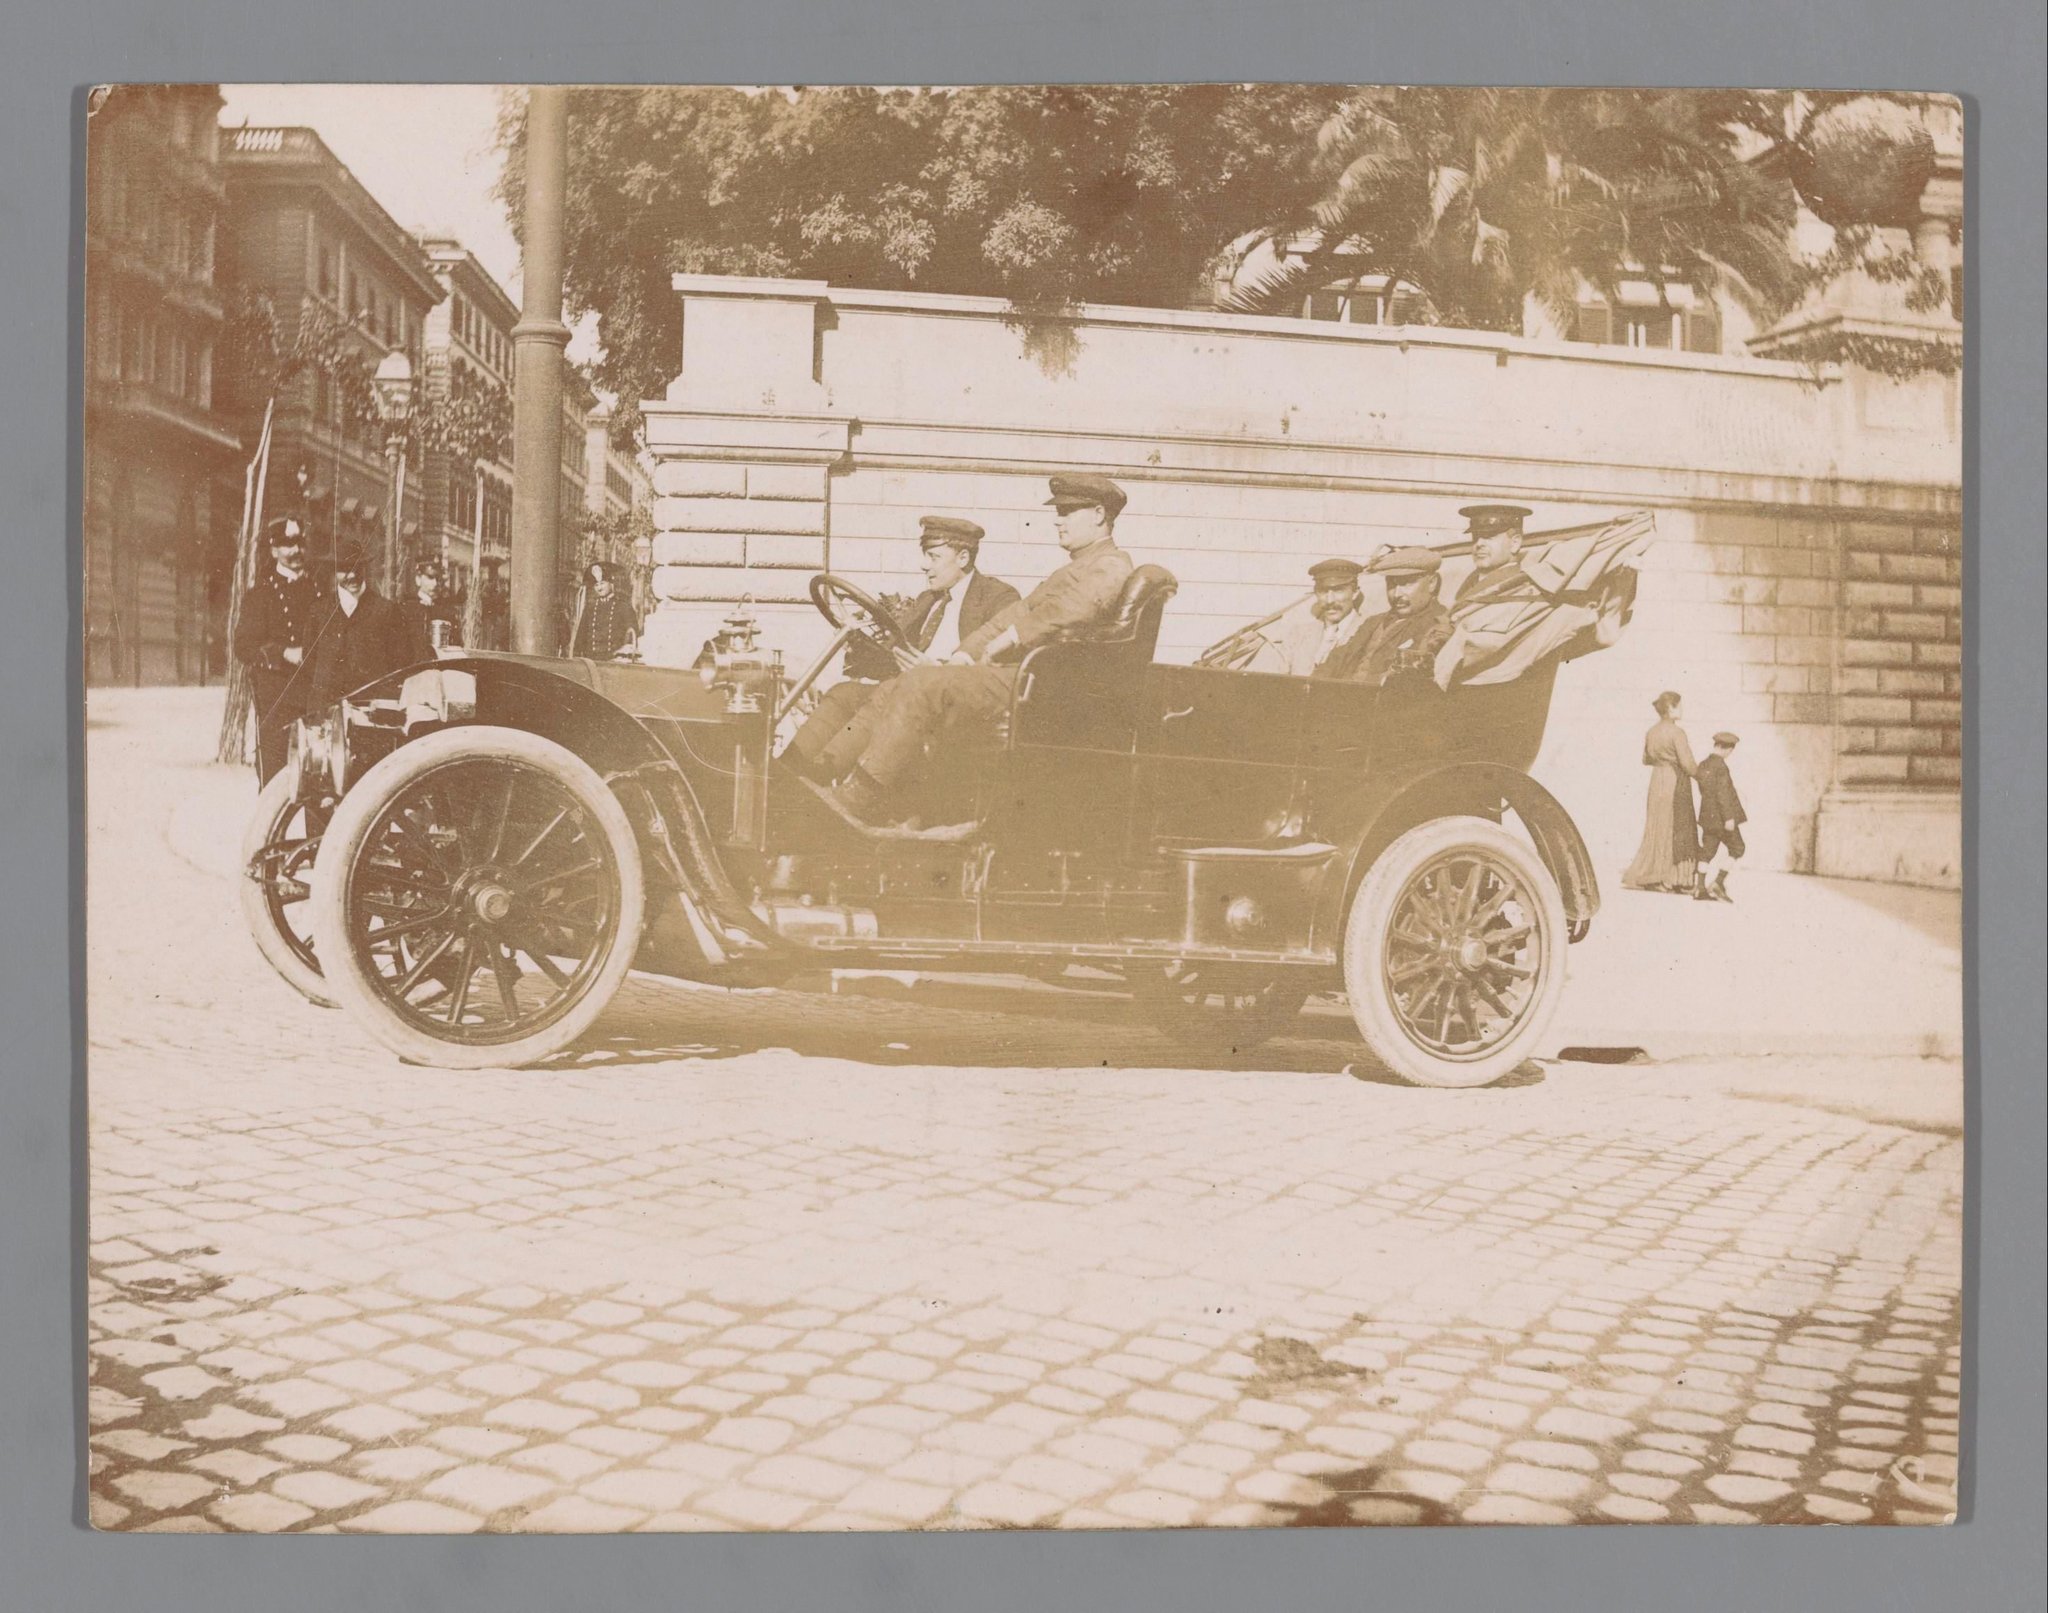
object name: photograph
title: Onbekend gezelschap in een auto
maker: Anonymous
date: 1915-1925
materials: photographic support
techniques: gelatin silver print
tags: automobile, street